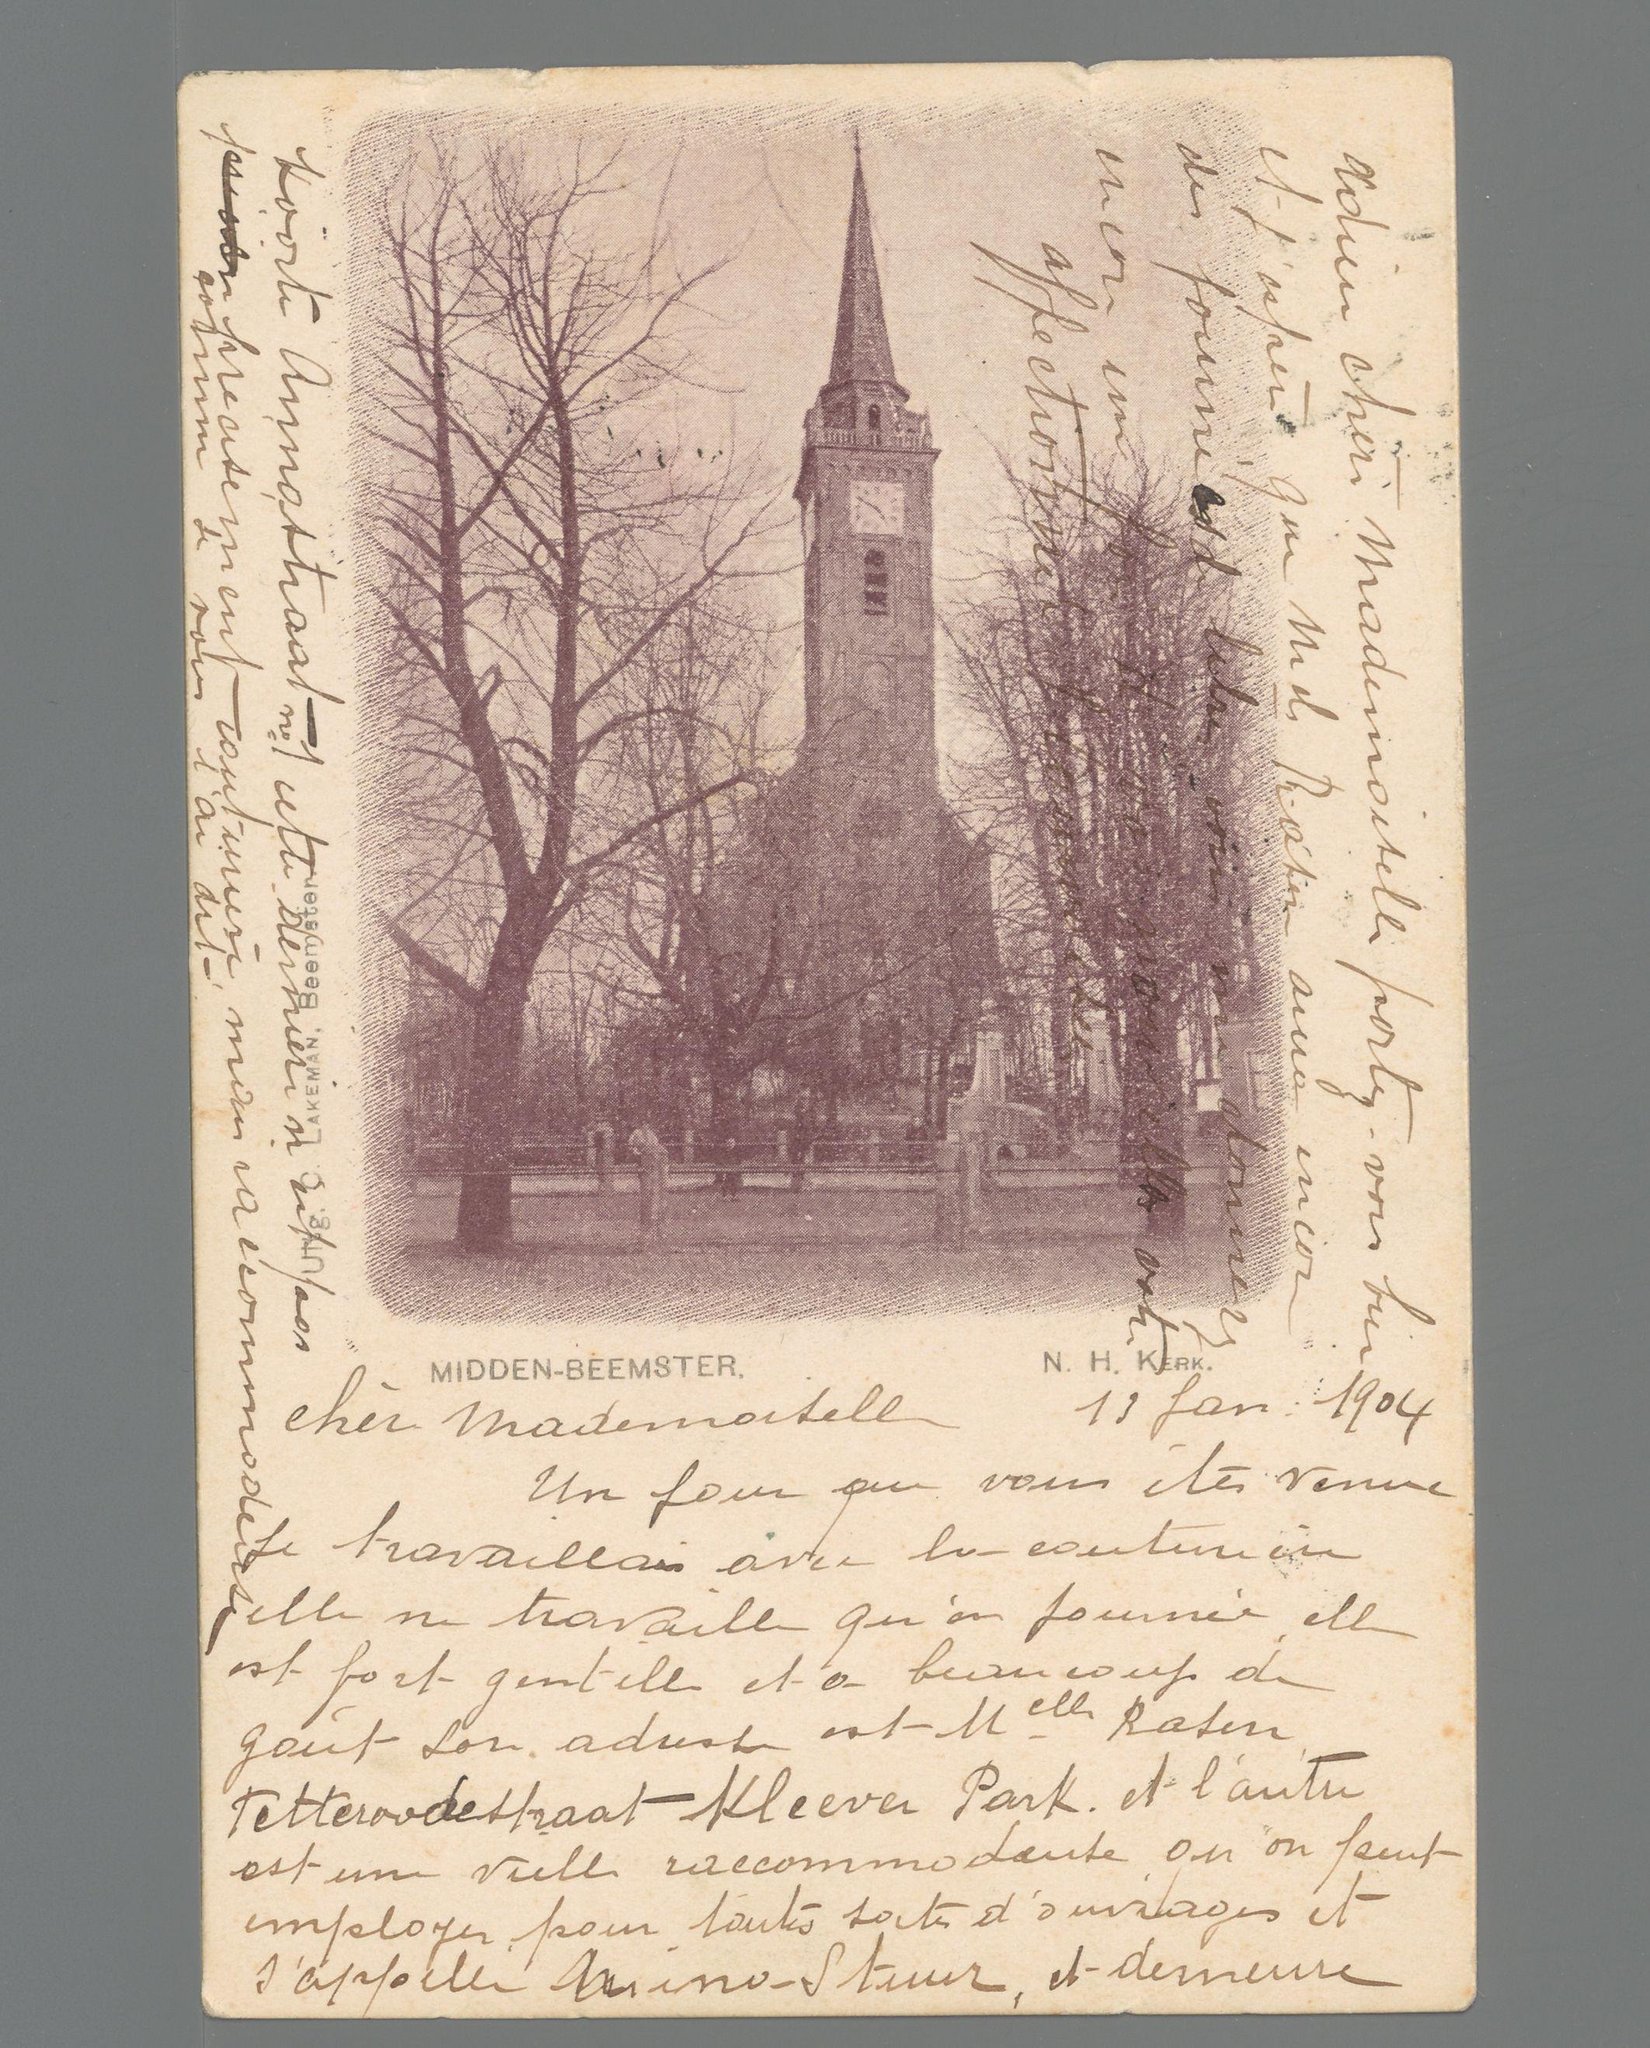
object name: ansichtkaart, prentbriefkaart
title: Midden-Beemster. N.H. Kerk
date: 1895-1901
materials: cardboard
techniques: writing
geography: beemster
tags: church (exterior)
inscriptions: postage stamp